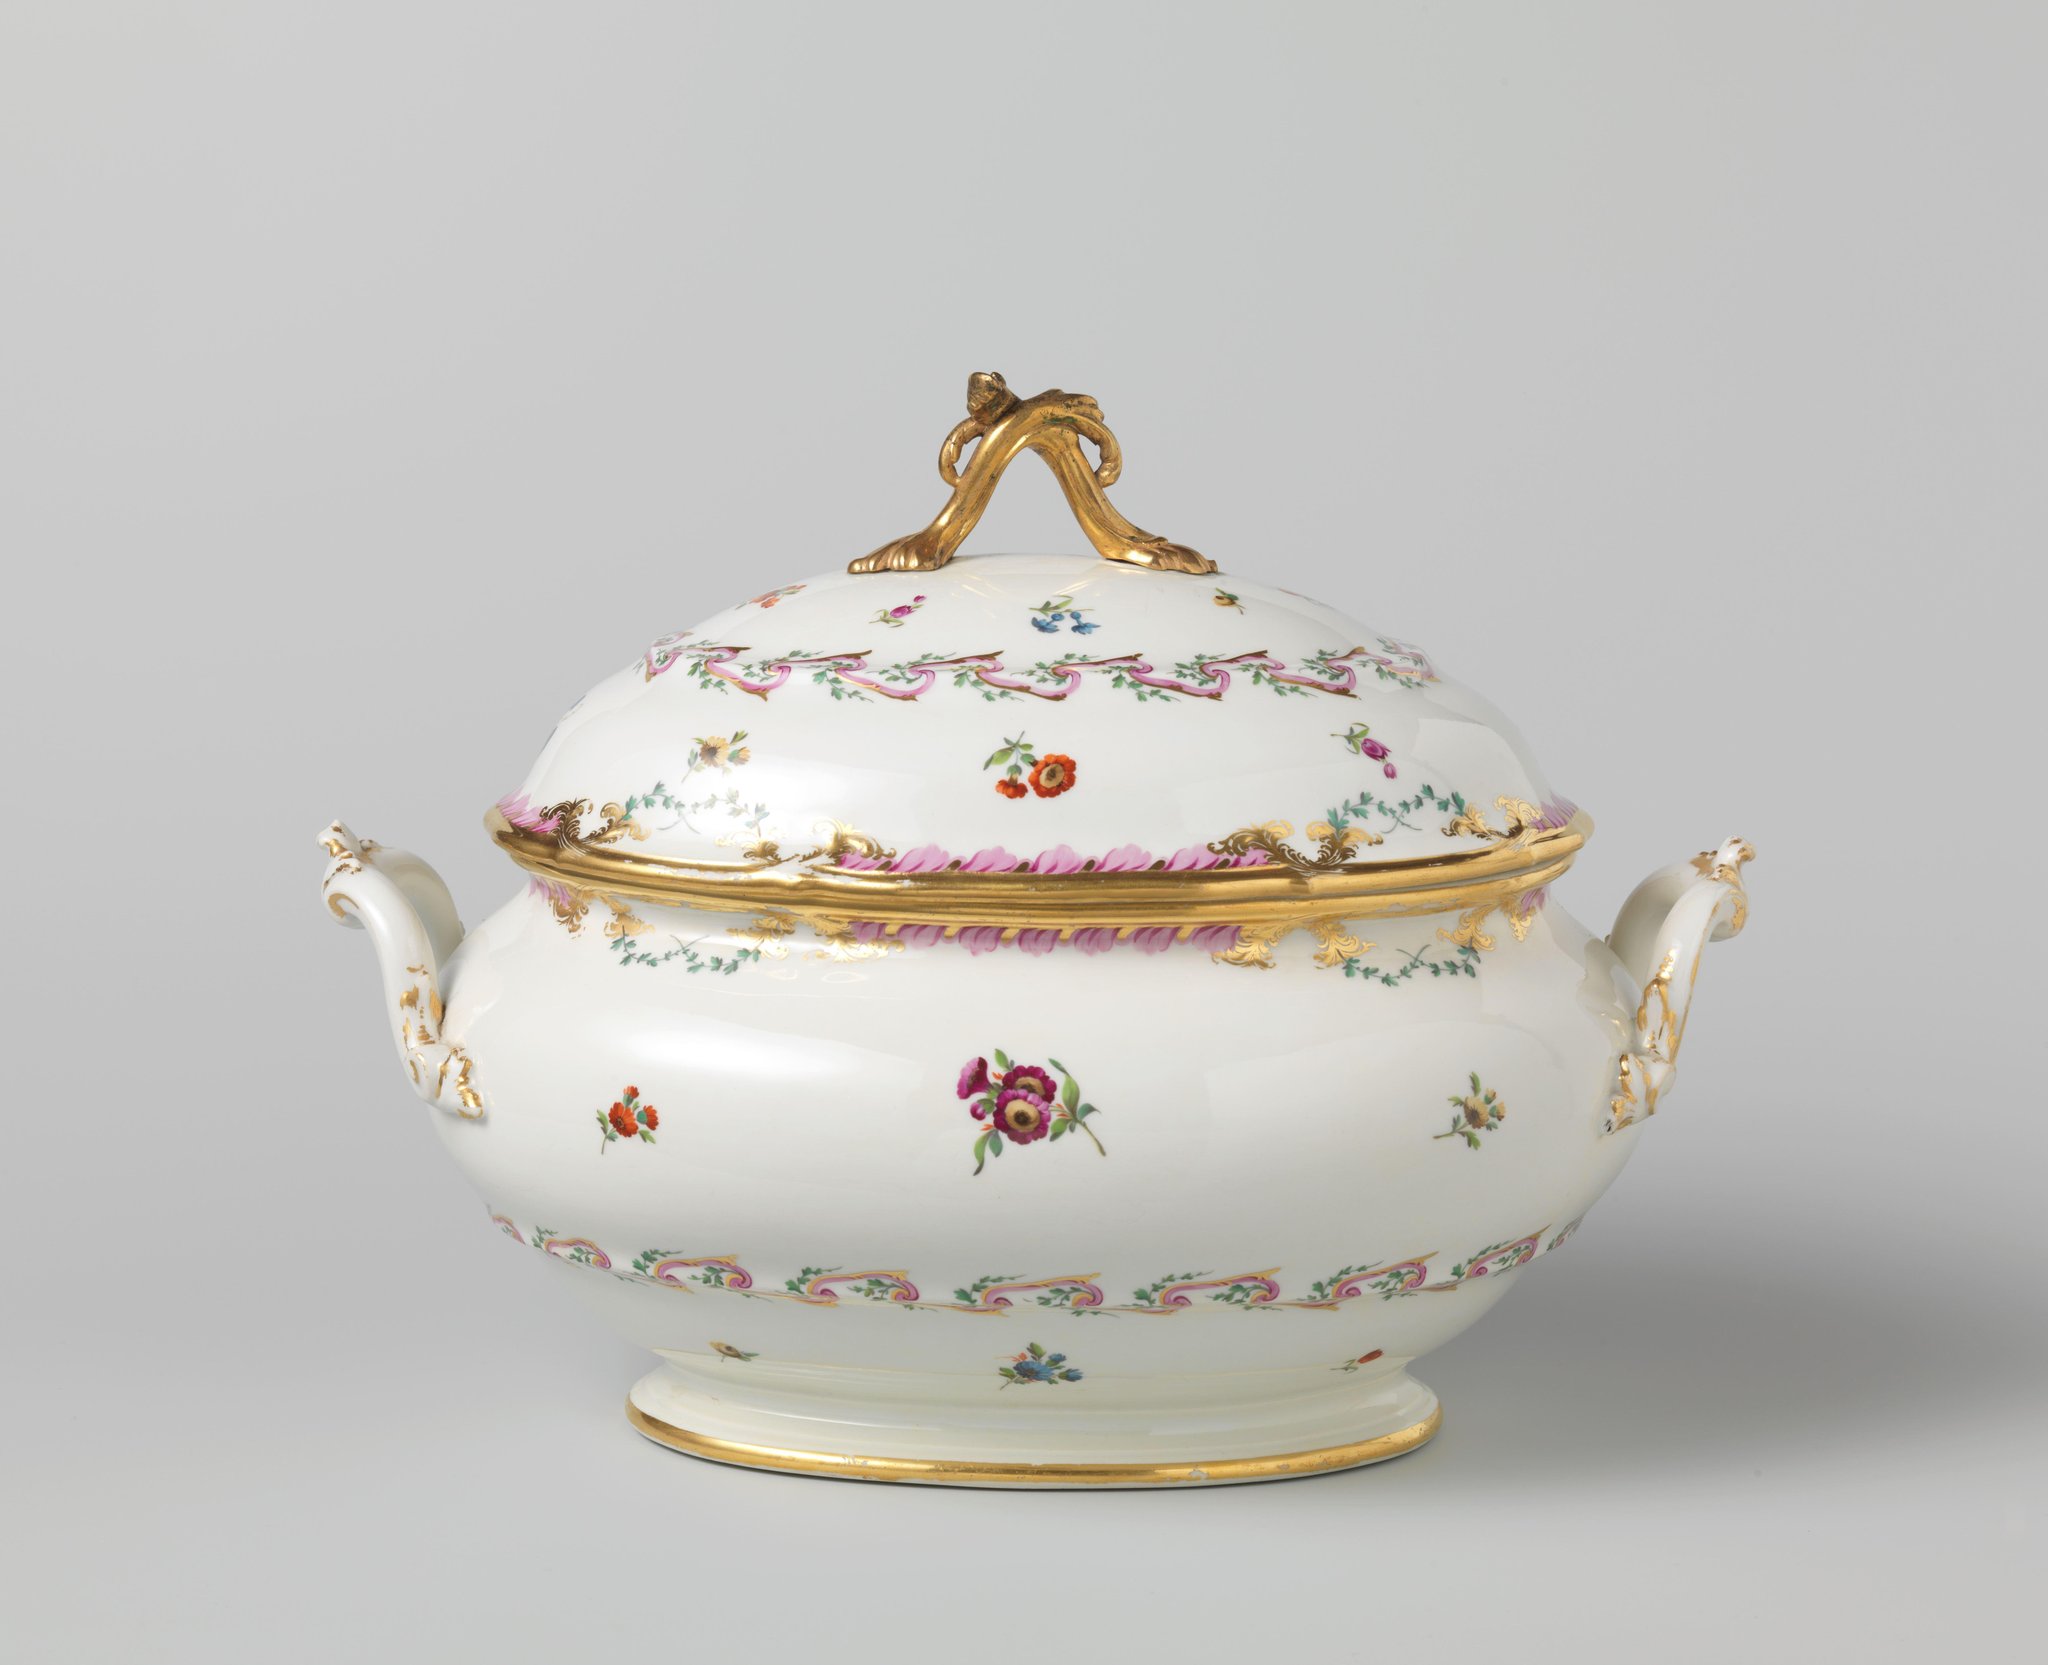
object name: tureen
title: Deksel van terrine met geslingerd lintmotief met bladertakken, bloemboeketten en gestrooide bloemtakken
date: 1780-1820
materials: porcelain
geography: amsterdam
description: Deksel van terrine, behorend bij een servies van porselein, versierd met een geslingerd lintmotief in paars en goud met groene bladertakken, bloemboeketten en gestrooide bloemtakken. Randen lichtgegolfd met decoratie in goud met paars bladmotief waartussen groen gekruist bladmotief. Vergulde knop niet origineel, later bijgemaakt. Gemerkt: M.O.L. en Amstel.